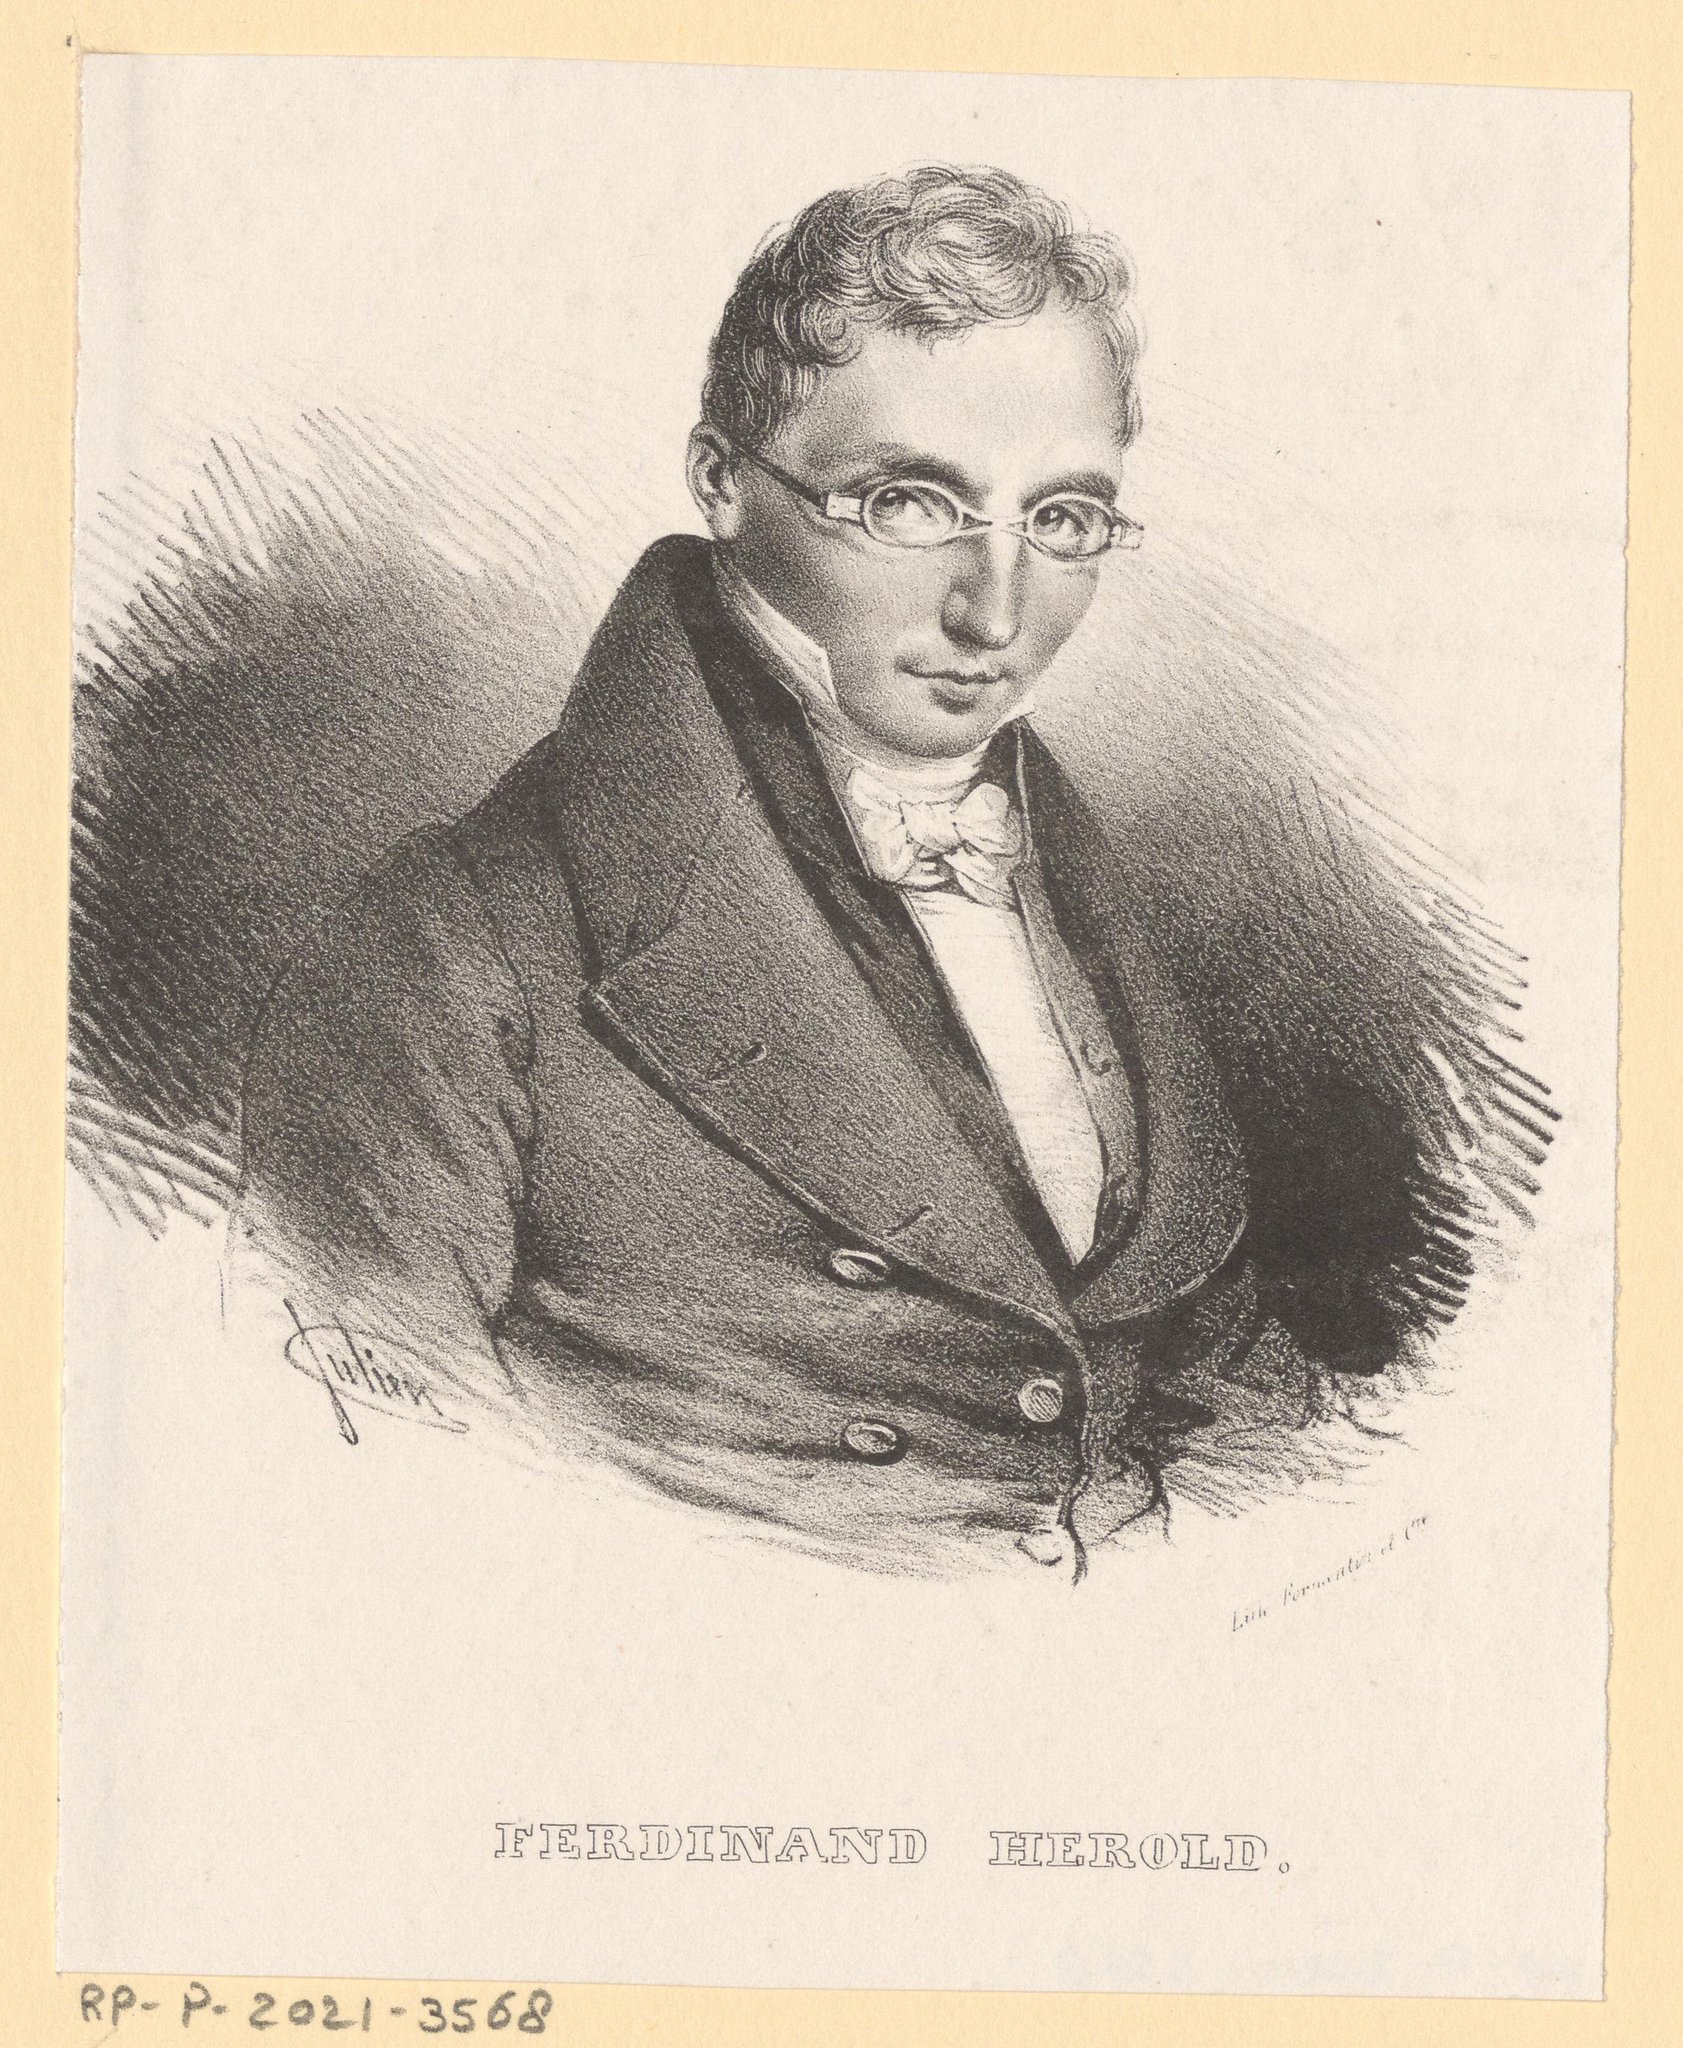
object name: print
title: Portret van Ferdinand Hérold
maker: bernard romain julien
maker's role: print maker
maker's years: 1802-1871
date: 1824-1856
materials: paper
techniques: lithograph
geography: paris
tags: eyeglasses, spectacles, historical persons, portrait of composer